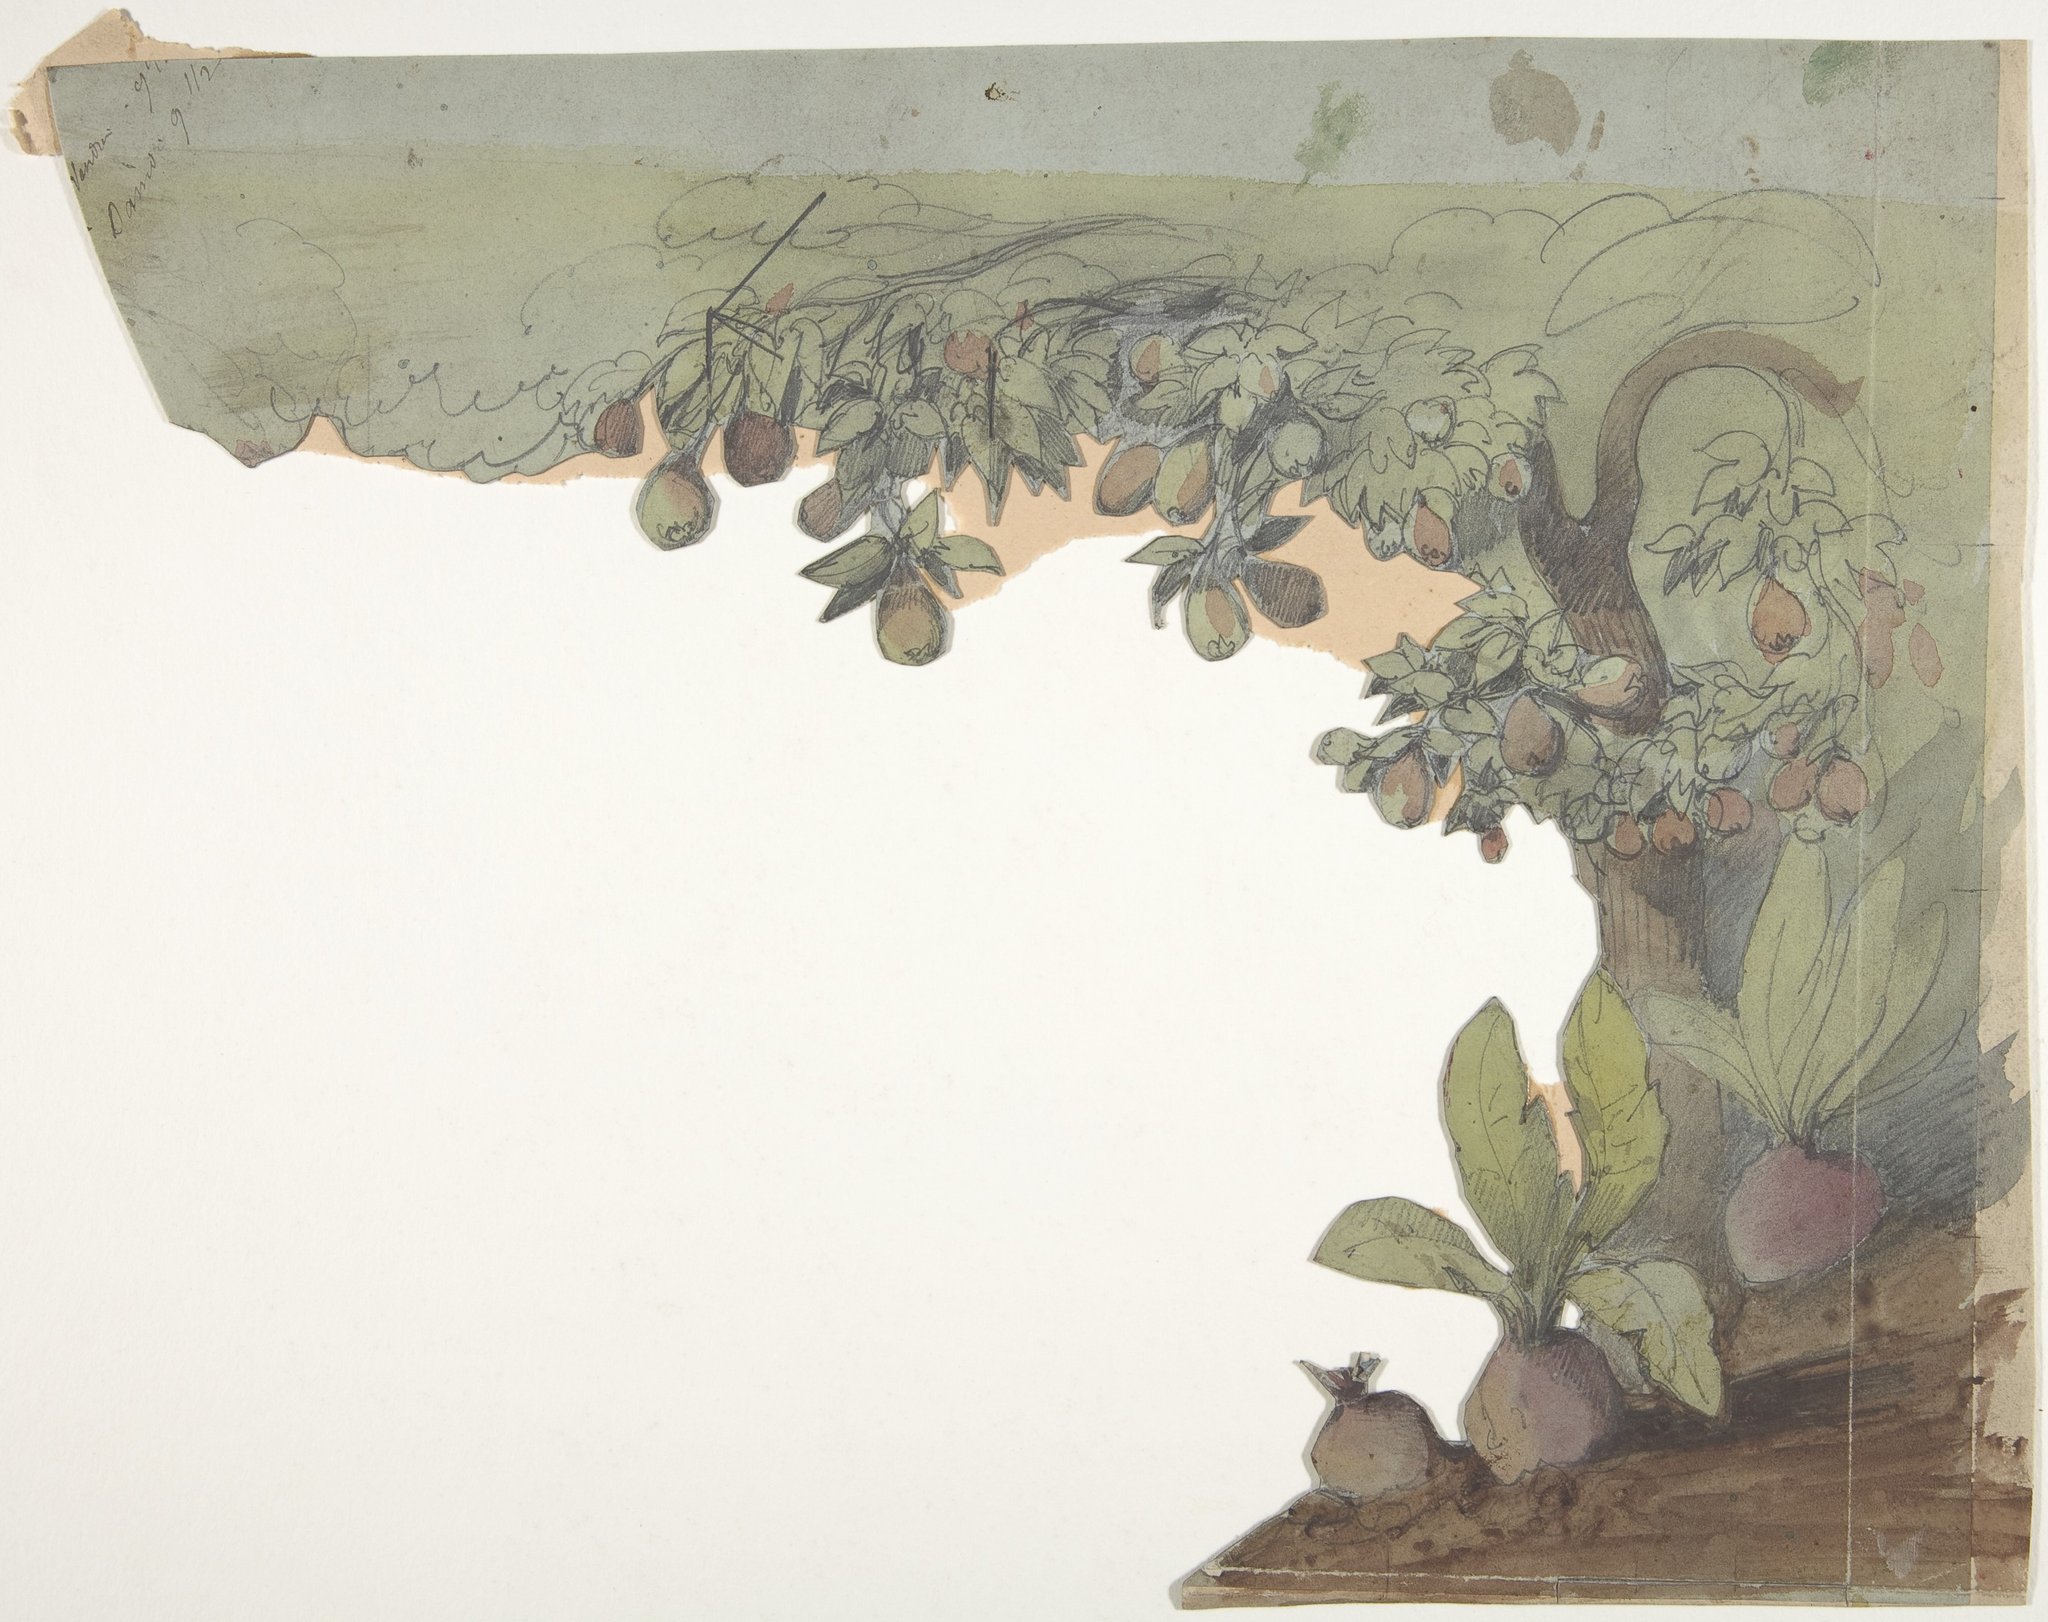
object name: drawing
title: Design for a Stage Set at the Opéra, Paris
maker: eugène cicéri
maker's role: artist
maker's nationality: french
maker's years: 1813-1890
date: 1830-1890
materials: graphite, watercolor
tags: fruit,stage design